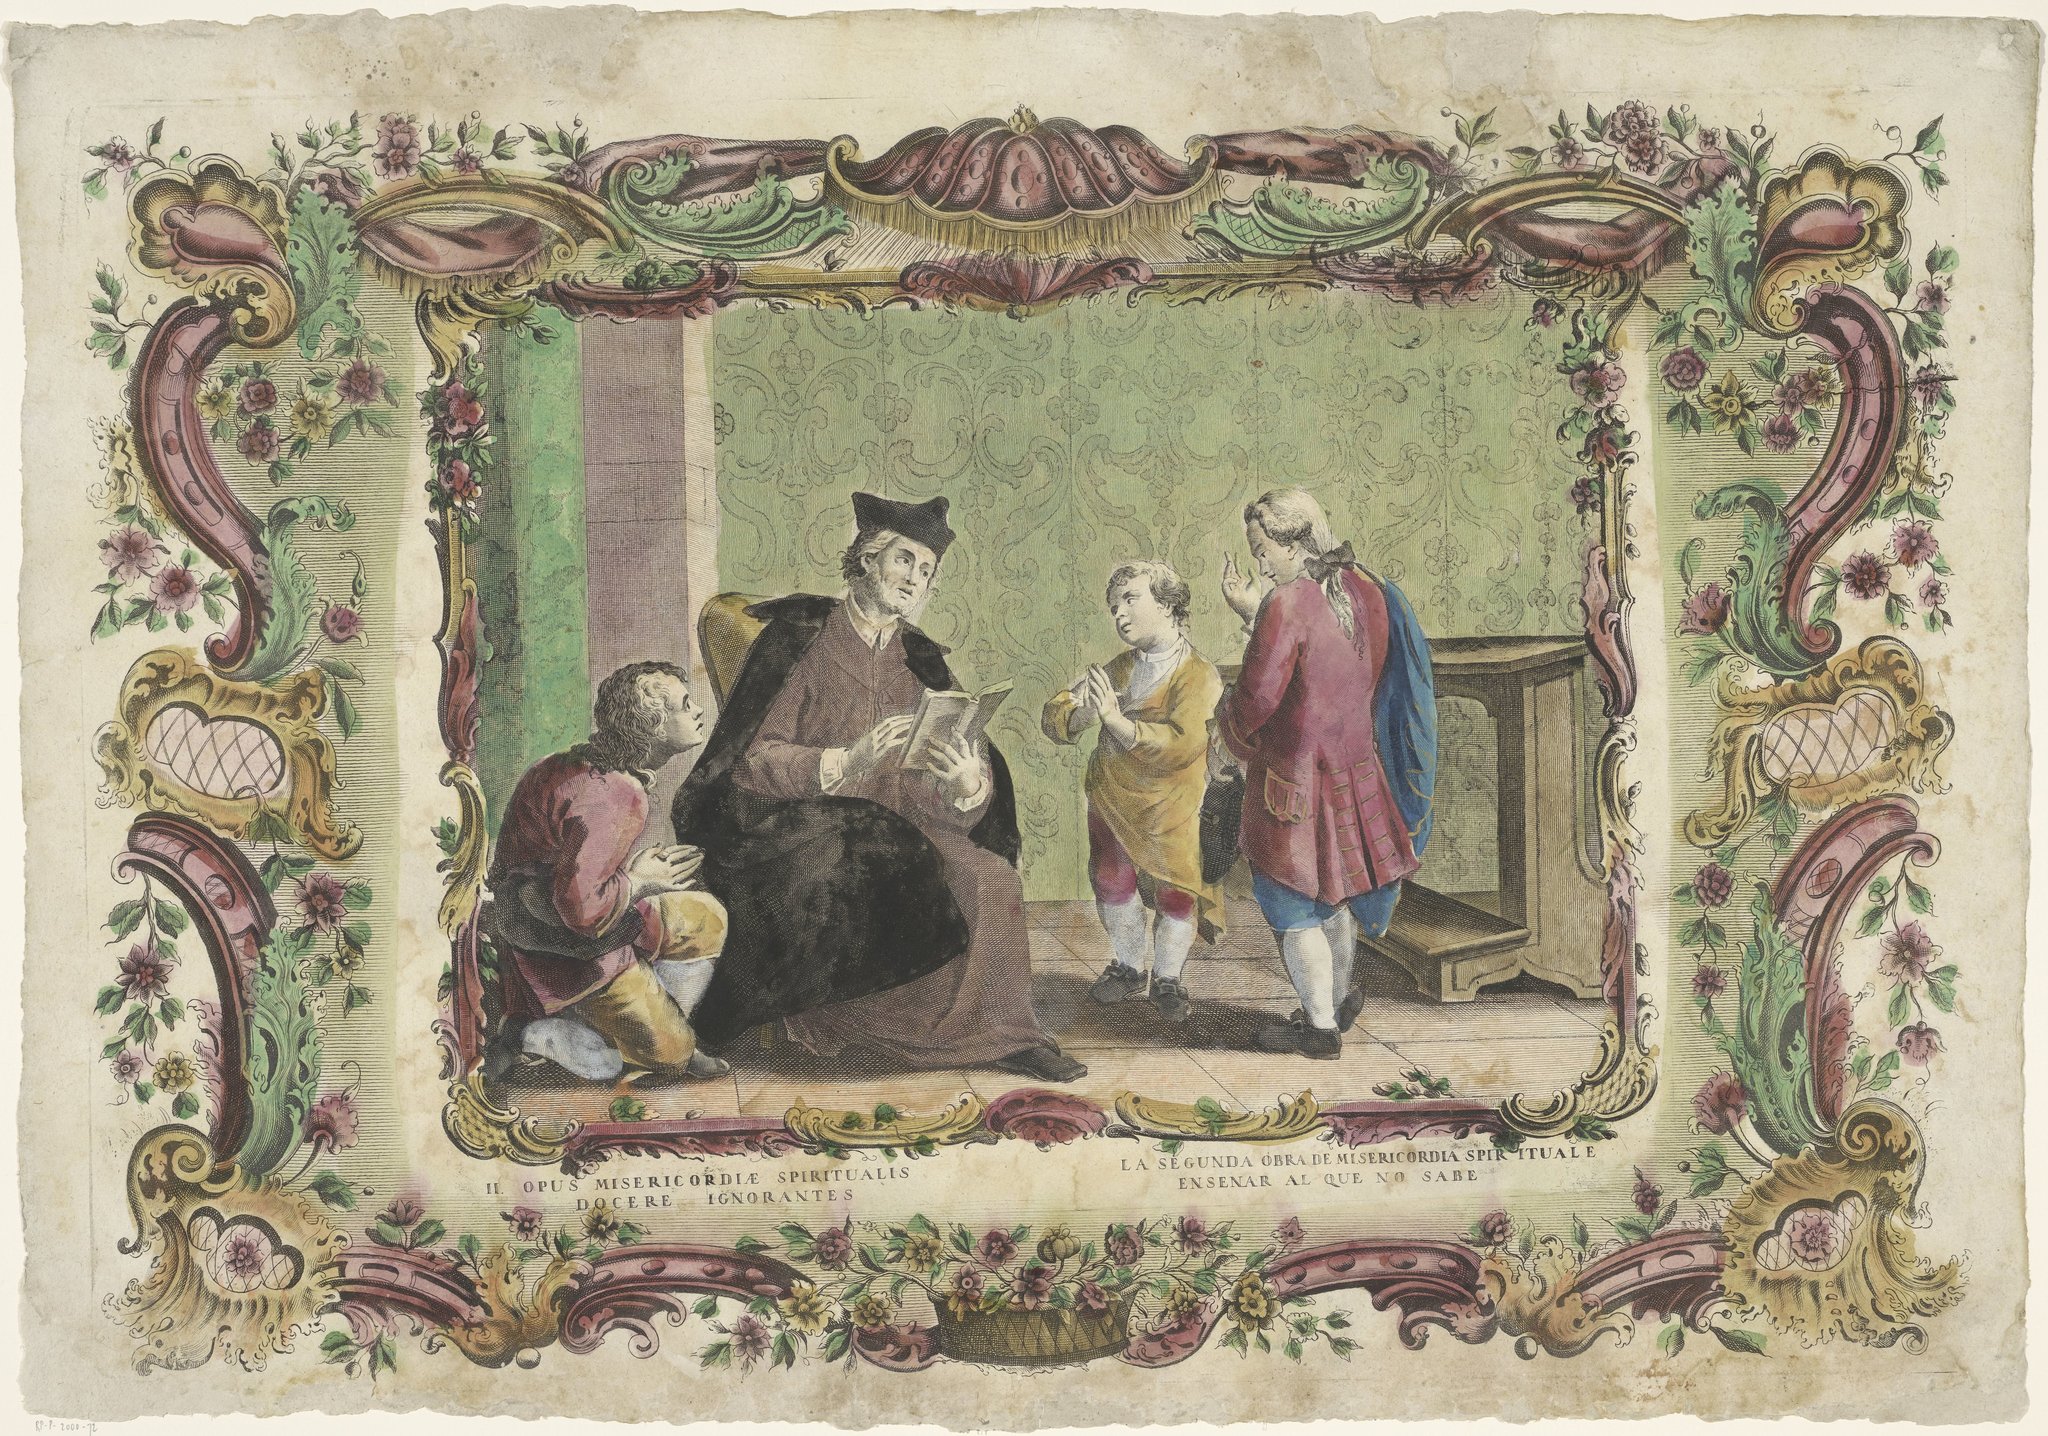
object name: print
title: II opus misericordiae spiritualis / La segunda obra de misericordia spiritual (...)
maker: giovanni volpato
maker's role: ceramicist, print maker, printer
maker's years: 1735-1803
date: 1700-1799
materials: paper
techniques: colour, engraving, etching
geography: bassano del grappa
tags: ornaments ~ art, informing the ignorant ~ one of the (seven) spiritual acts of mercy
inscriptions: collector's mark: Lugt 2228, collector's mark: Lugt 2760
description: Uitbeelding van één van de spirituele werken van barmhartigheid: het onderwijzen van de onwetenden. In een vertrek zit een priester die drie jongens leert bidden. Hij heeft een open boek in de handen. Een van de jongens maakt een kruisteken, de twee andere hebben de handen gevouwen. Titel onder de voorstelling. De scène is gevat in een ornamentrand.